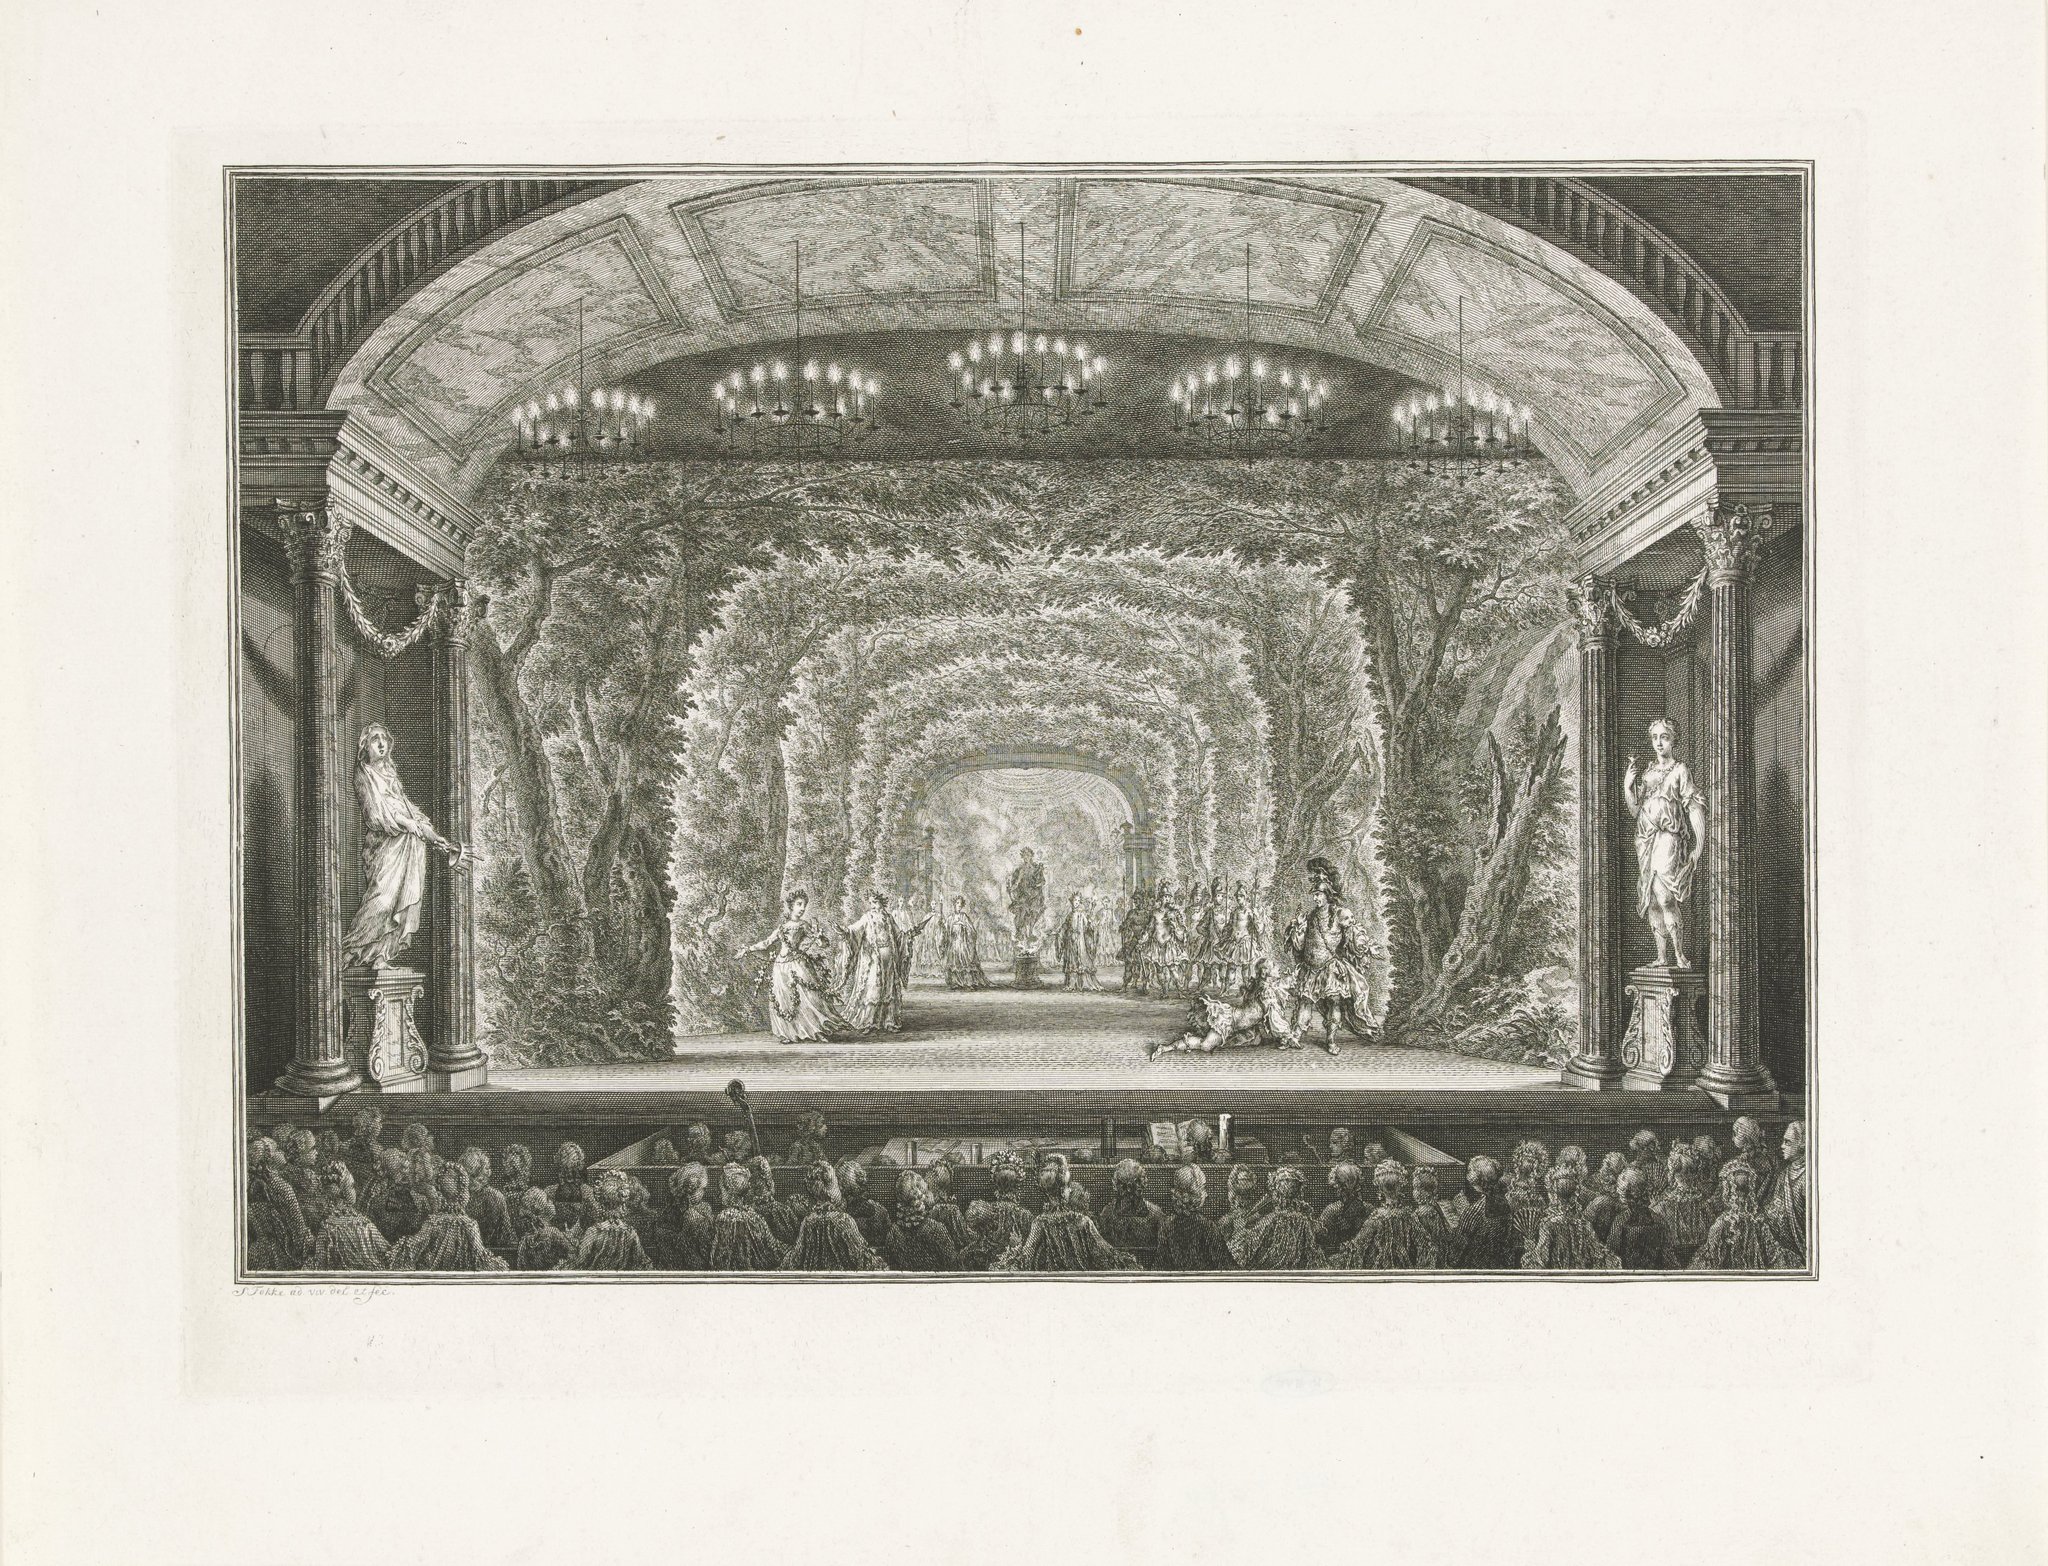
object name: print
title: Toneelvoorstelling in de Amsterdamse Schouwburg voor het prinselijk paar, 1768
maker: simon fokke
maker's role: draughtsman, print maker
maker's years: 1712-1784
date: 1772-1773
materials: paper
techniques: engraving, etching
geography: northern netherlands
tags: the hague, william v (prince of orange), berlin, painter, draughtsman, wilhelmina of prussia (princess of orange), public festivities on the occasion of royal events, theatre, theatrical performance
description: Toneelvoorstelling van het treurspel Demophontes voor de stadhouder Willem V en prinses Wilhelmina van Pruisen in de nieuwe Amsterdamse Schouwburg aan de Keizersgracht, 1 juni 1768. Onderdeel van een prentserie met titelprent en 14 platen van de inhaling van de prins en prinses te Amsterdam, 30 mei - 4 juni 1768.